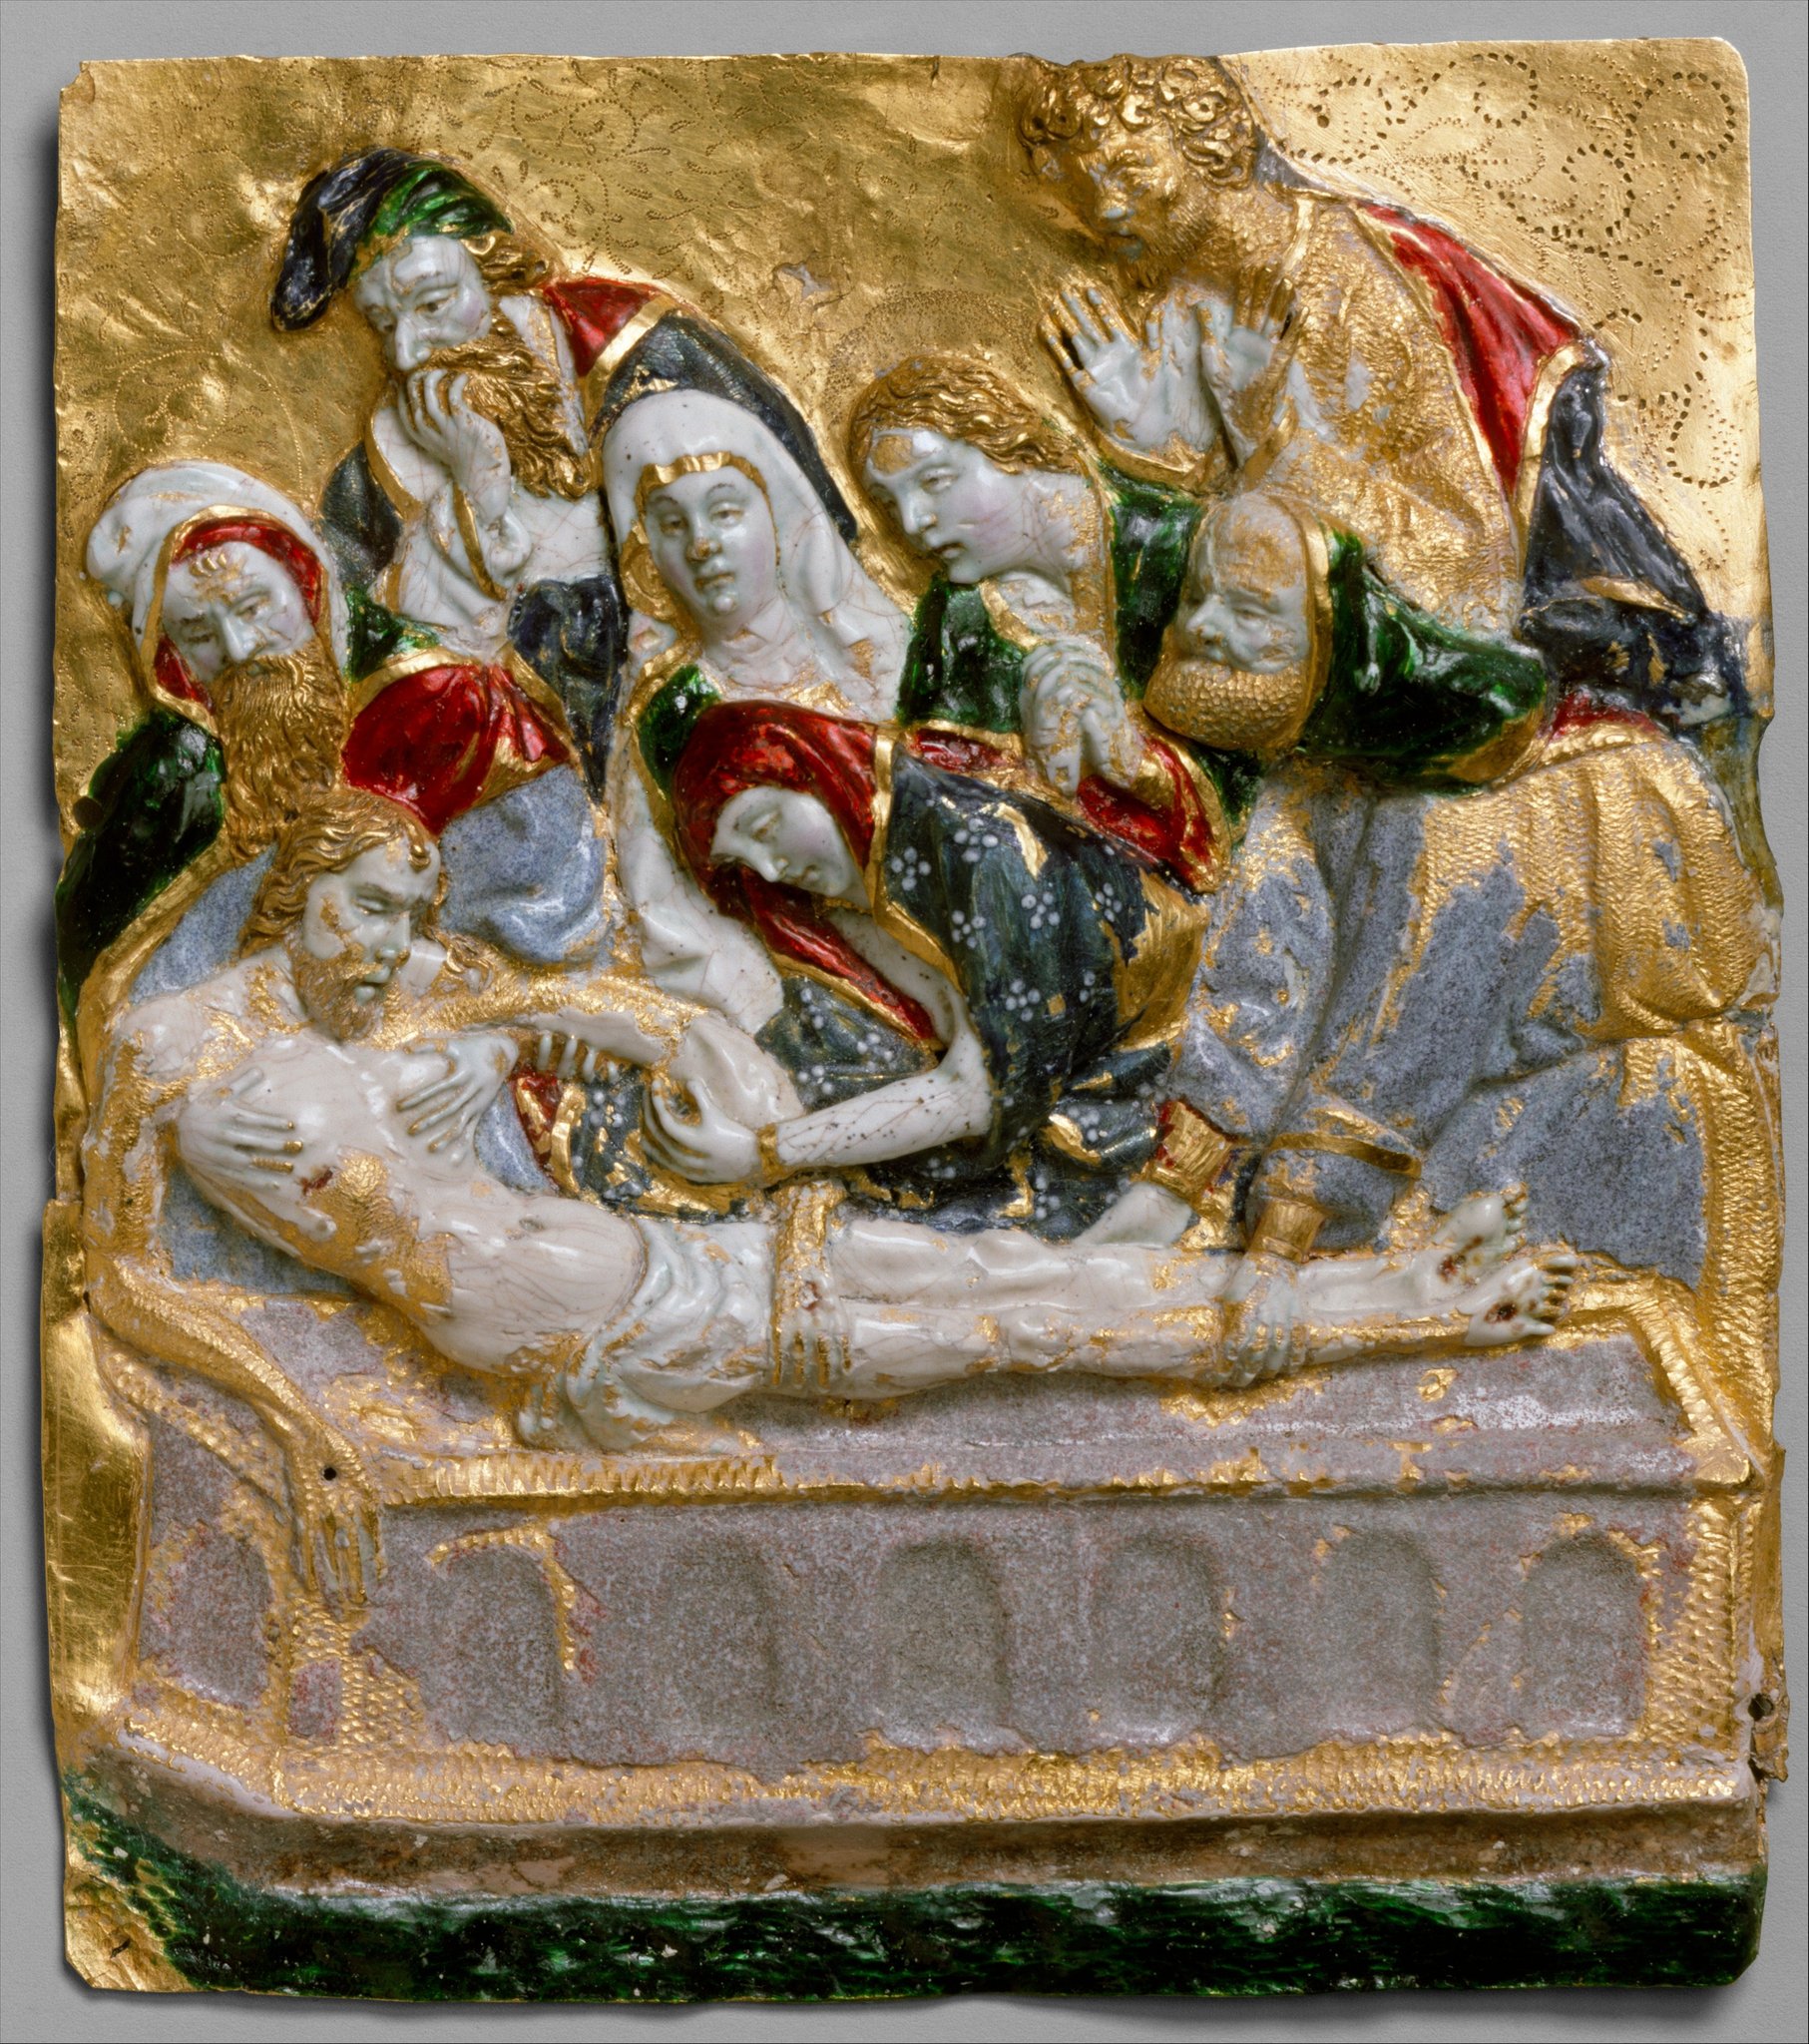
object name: panel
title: The Entombment of Christ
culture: french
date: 1390-1405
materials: enamel, gold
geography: france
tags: christ,virgin mary,entombment